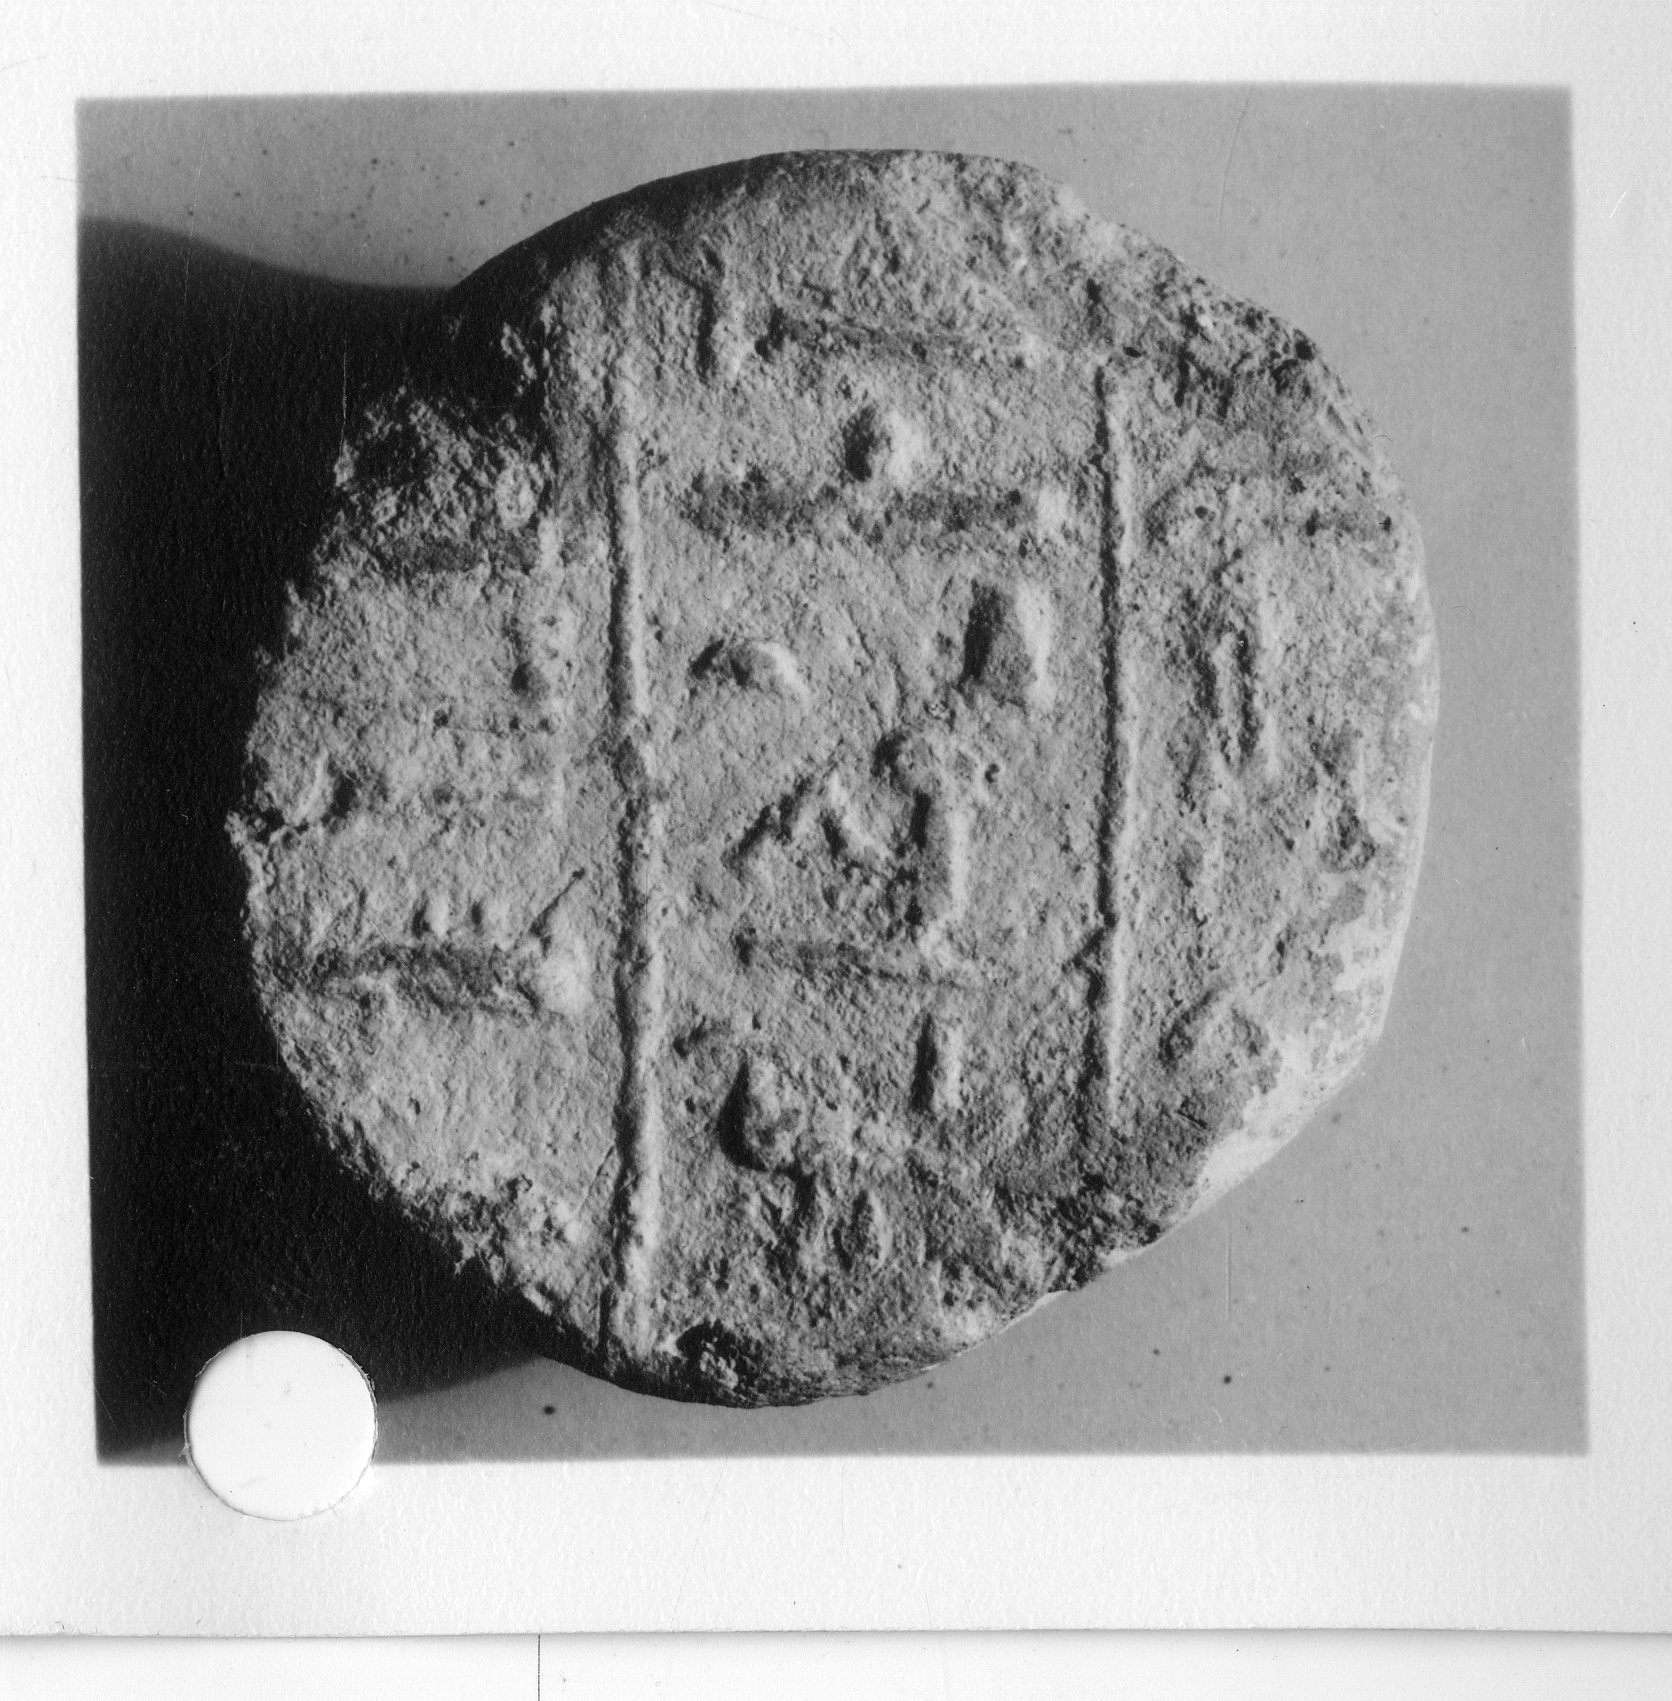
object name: cone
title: Funerary Cone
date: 1550-1295 BCE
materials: pottery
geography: egypt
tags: hieroglyphs